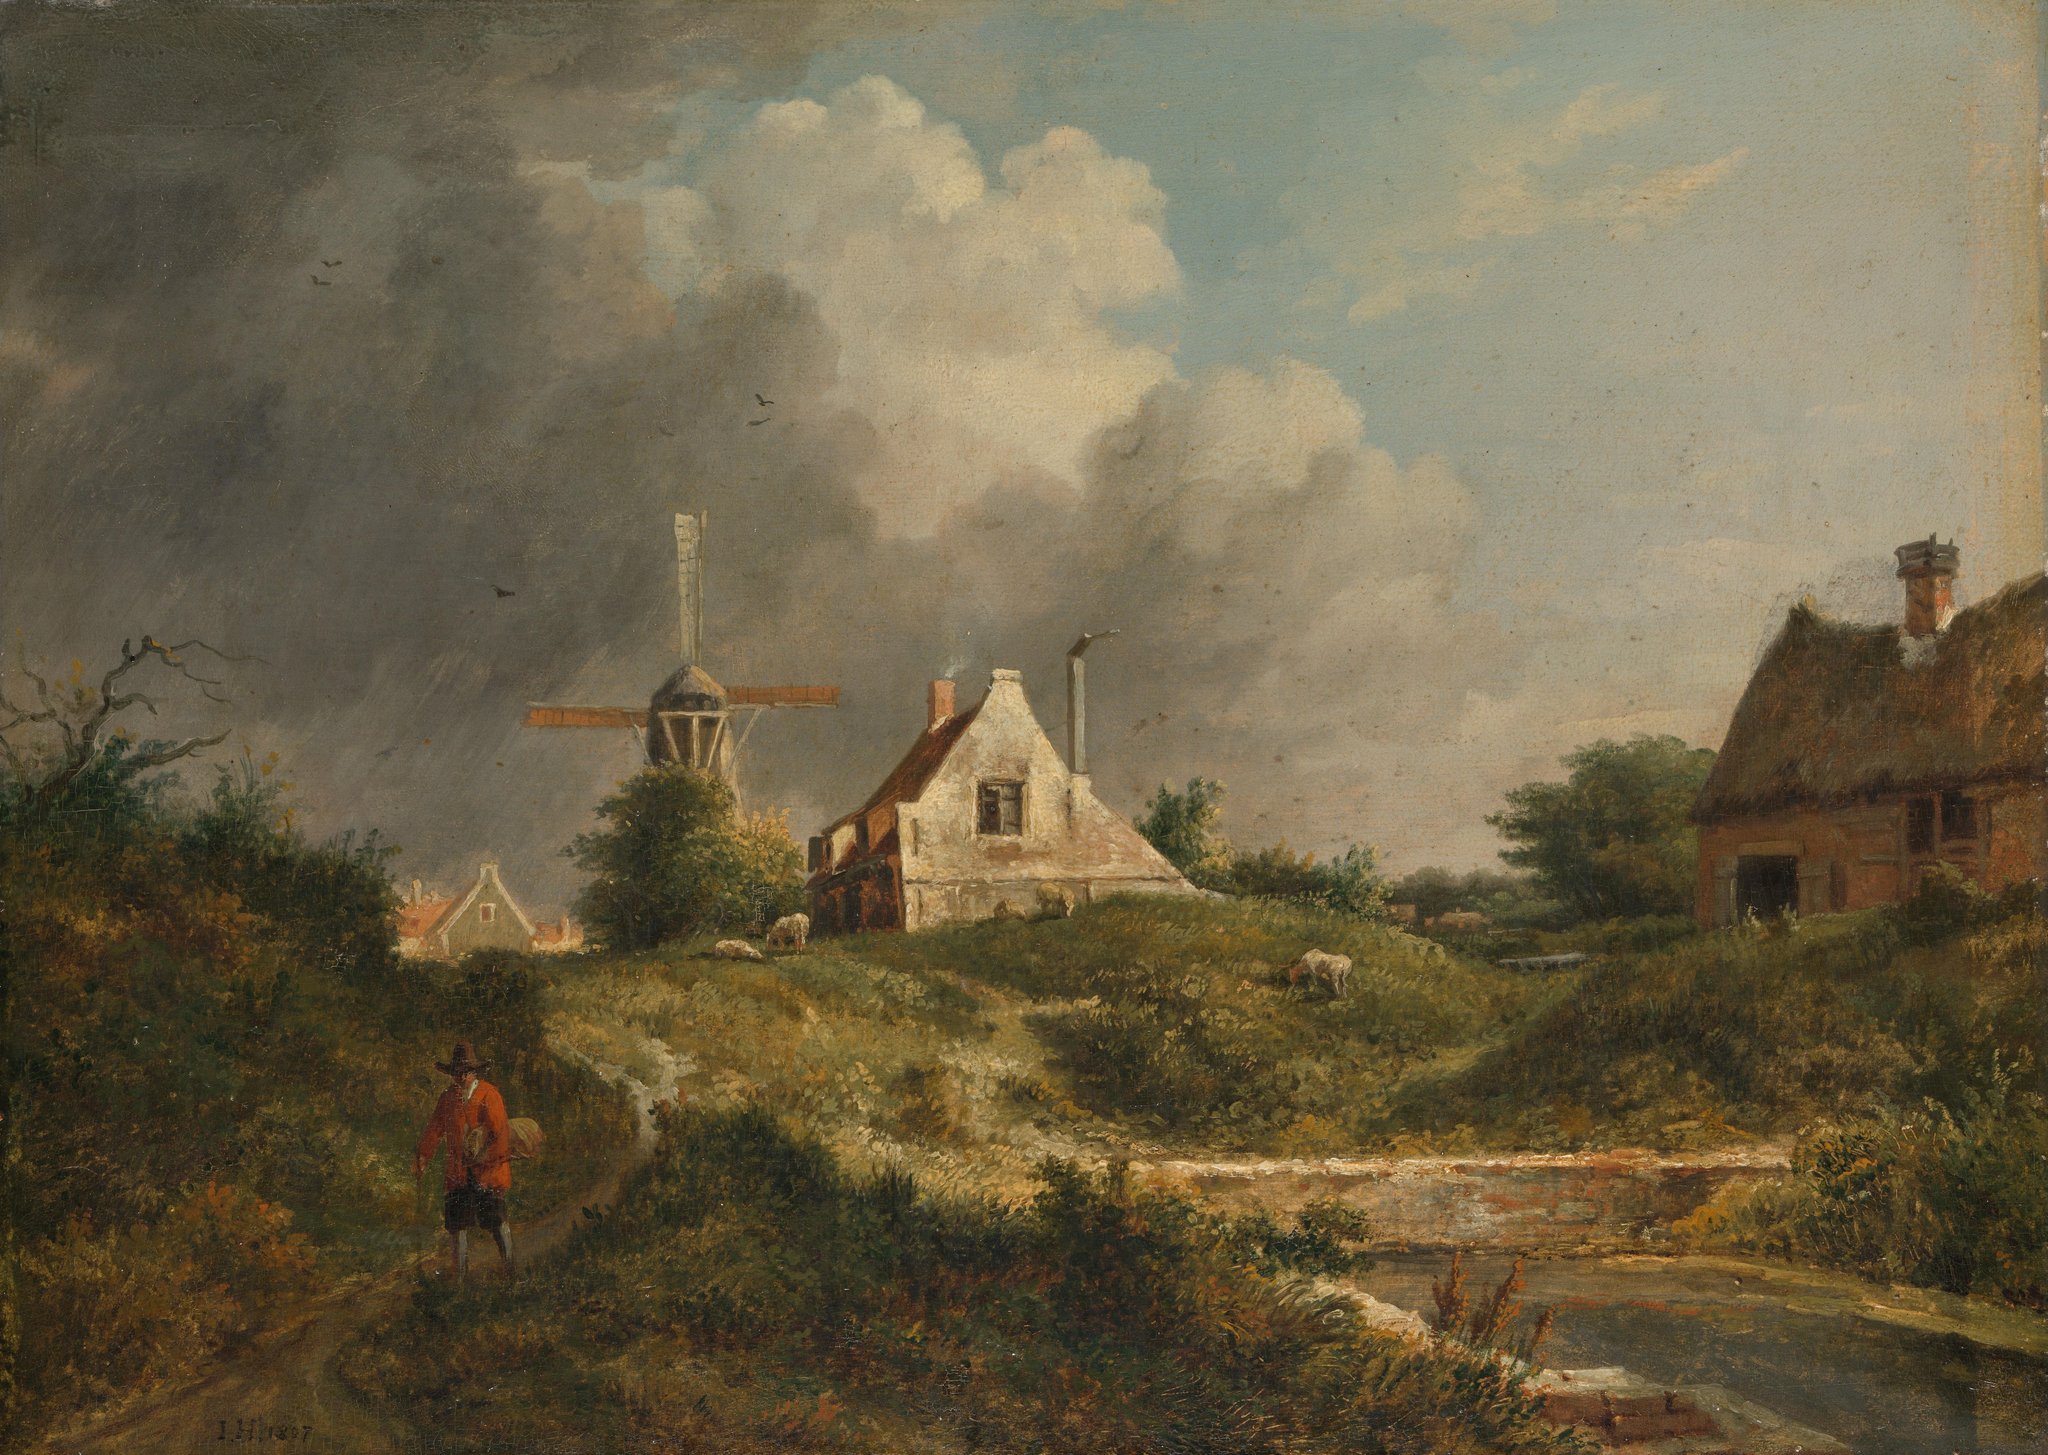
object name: painting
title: Landscape in the Gooi District of Noord-Holland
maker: jan hulswit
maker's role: draughtsman, painter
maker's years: 1766-1822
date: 1807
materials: oil, panel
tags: city-walls, outskirts of city, amsterdam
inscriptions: signature and date: ‘I. H. 1807’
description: Jan Hulswit (1766 - 1822). Landscape in the Gooi district of Holland, 1807.